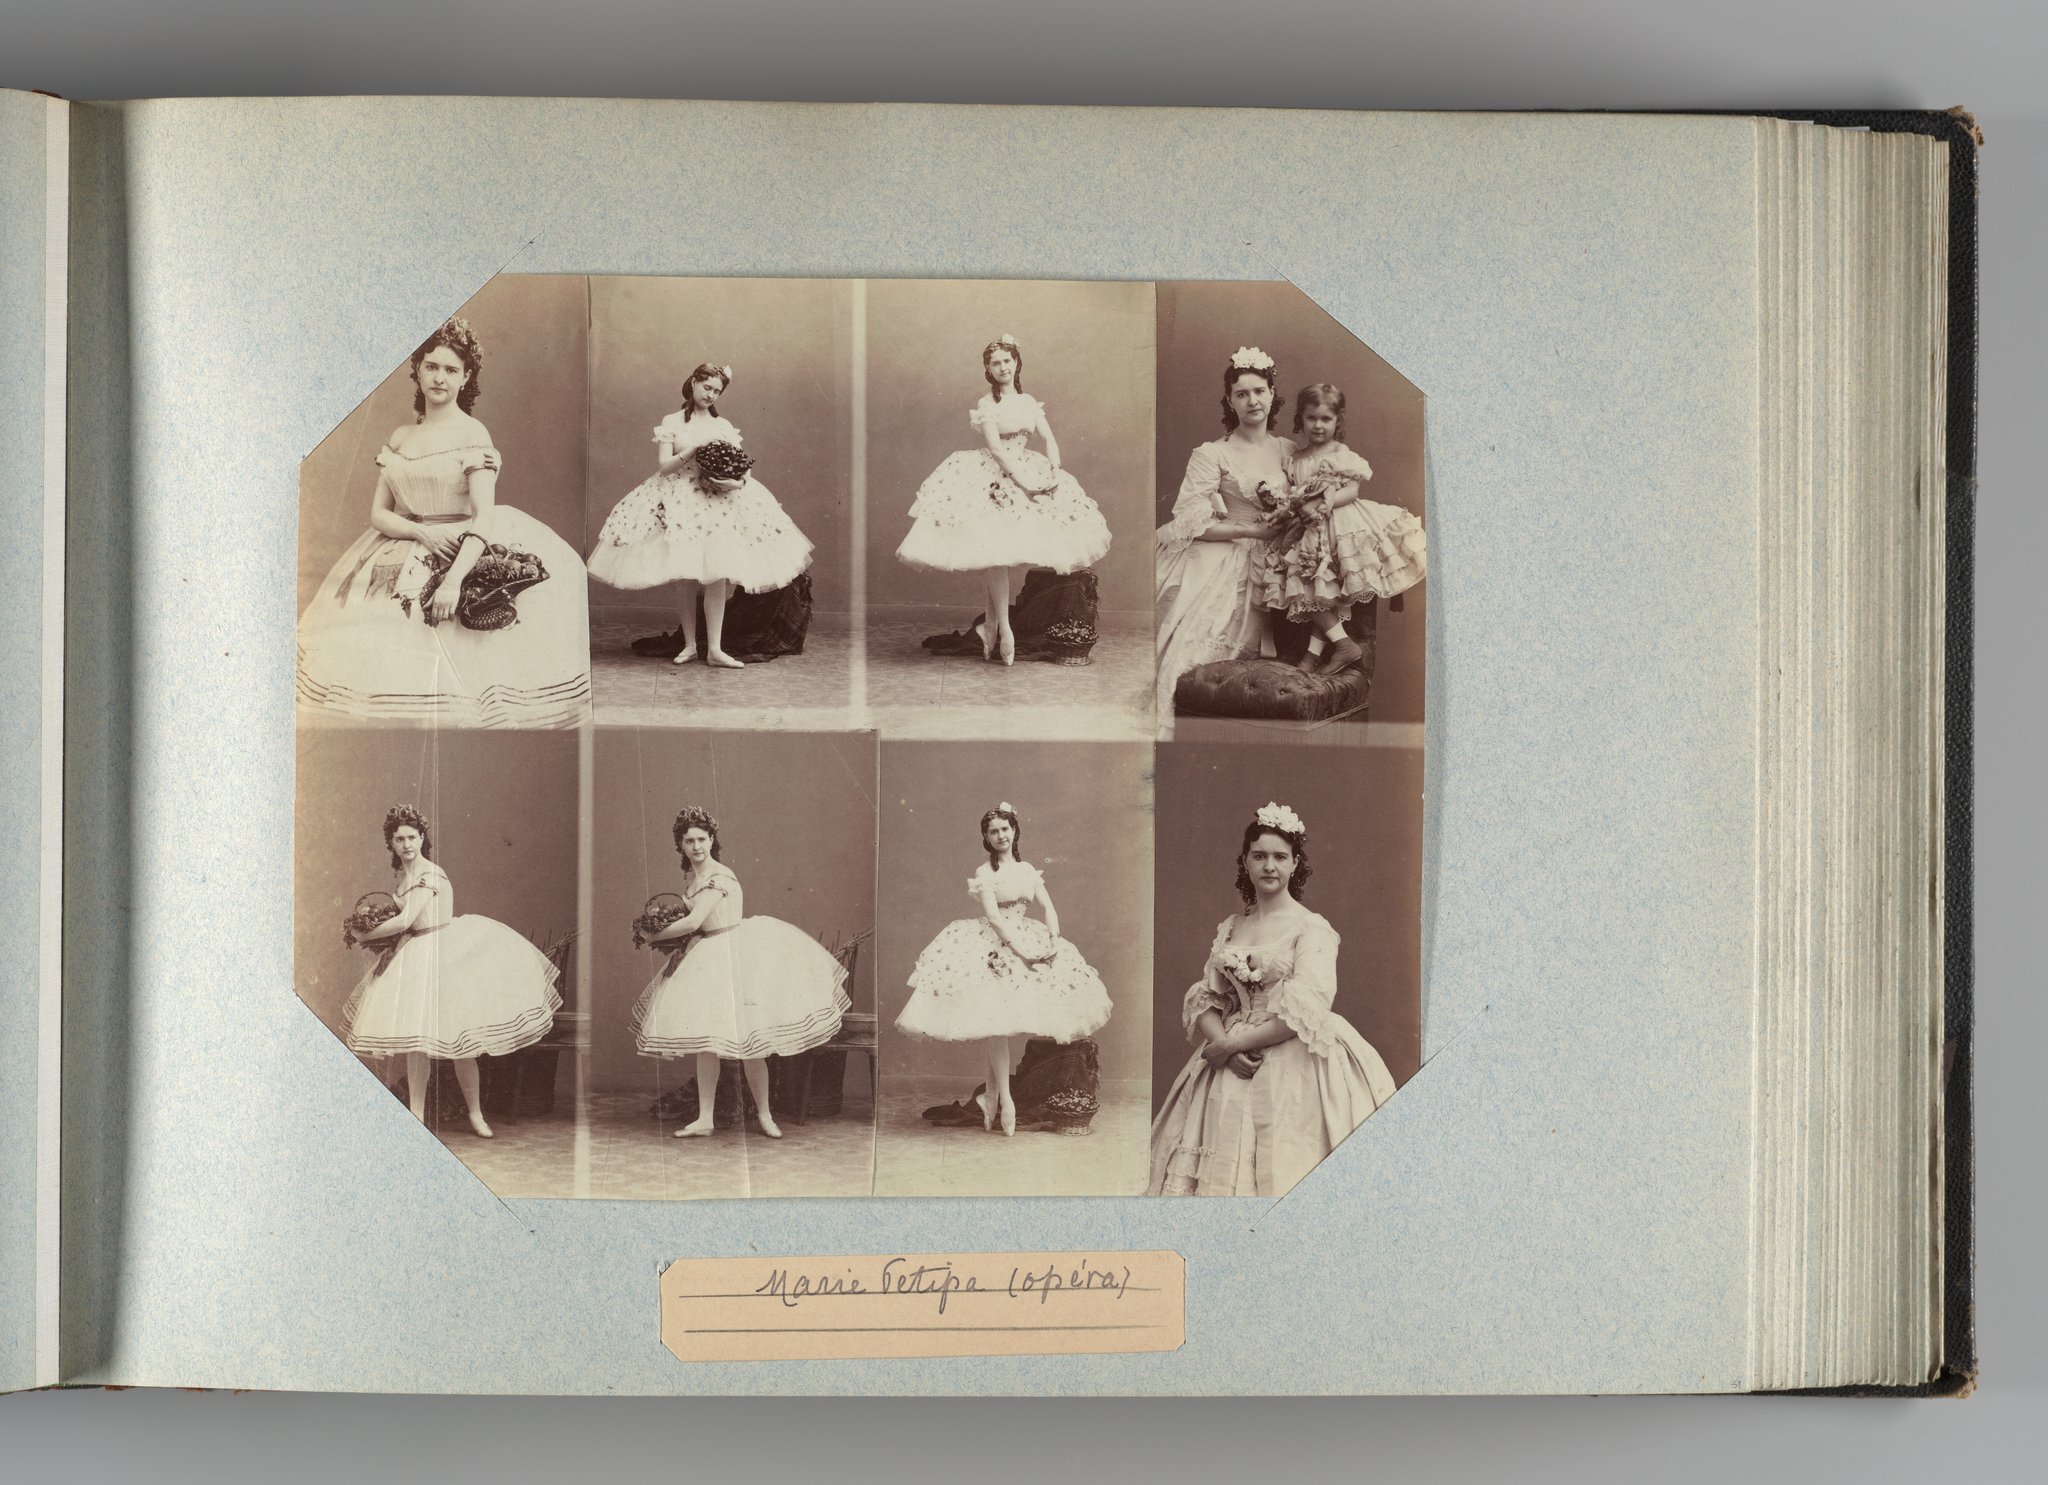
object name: photograph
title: Marie Petipa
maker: andré-adolphe-eugène disdéri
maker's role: artist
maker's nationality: french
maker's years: 1819-1889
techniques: albumen silver print, glass negative